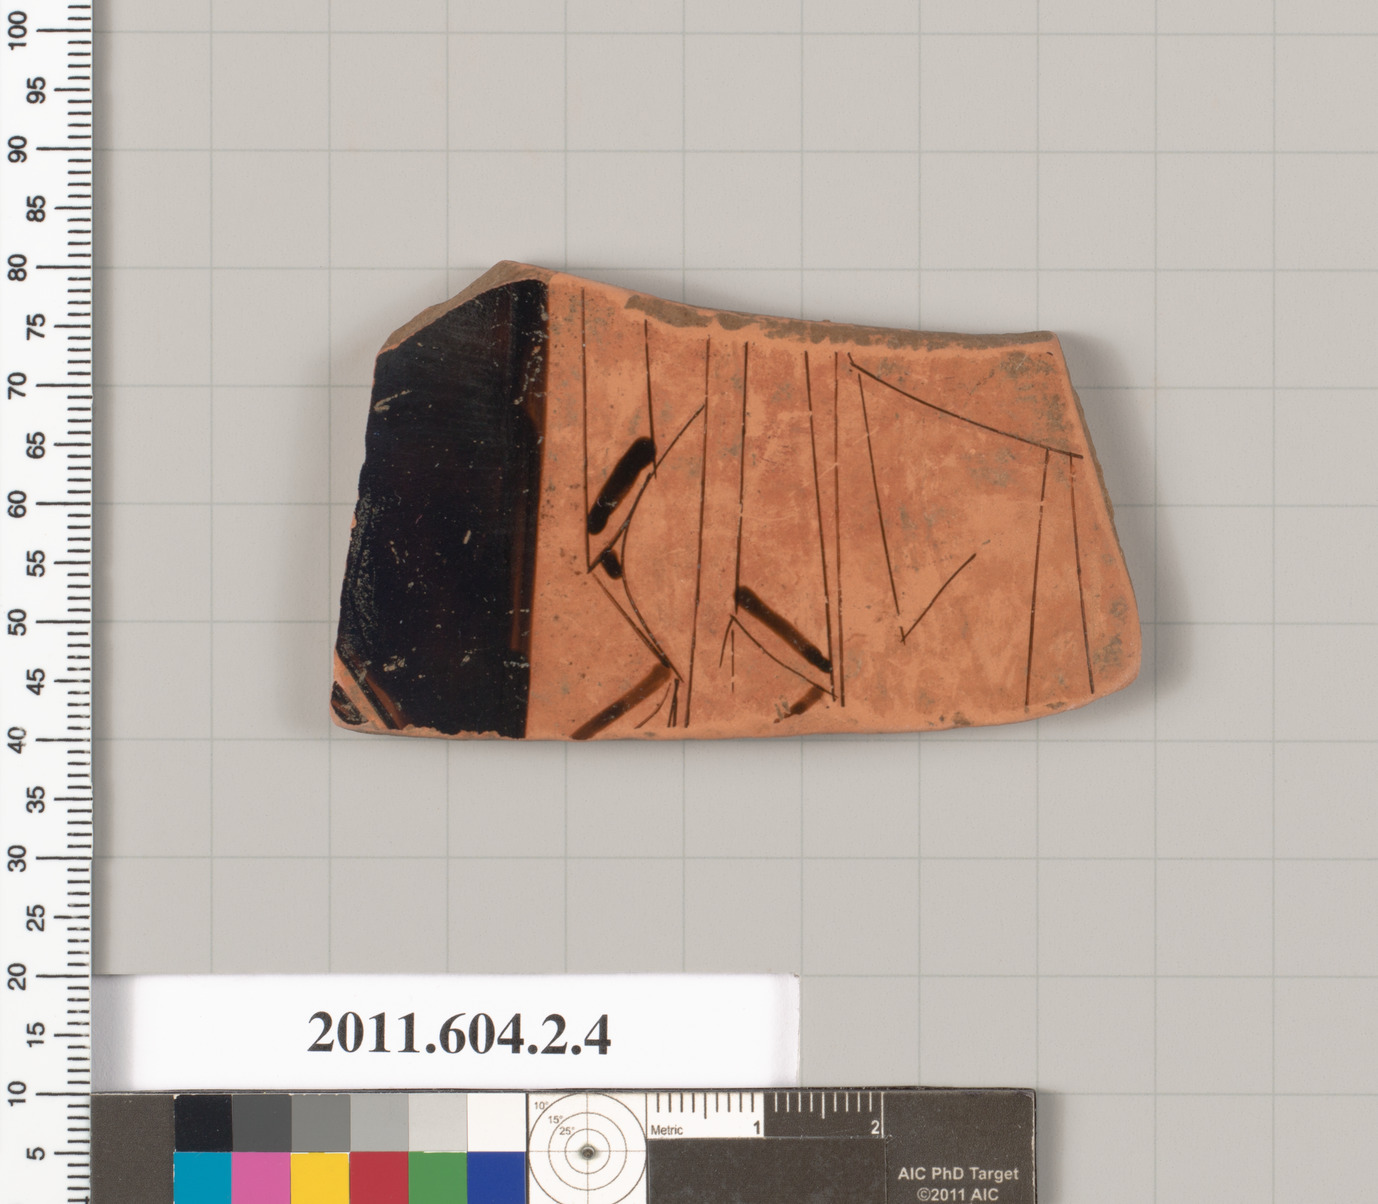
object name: neck amphora fragment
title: Terracotta fragment of a neck-amphora (jar)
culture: greek, attic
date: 475-451 BCE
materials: terracotta